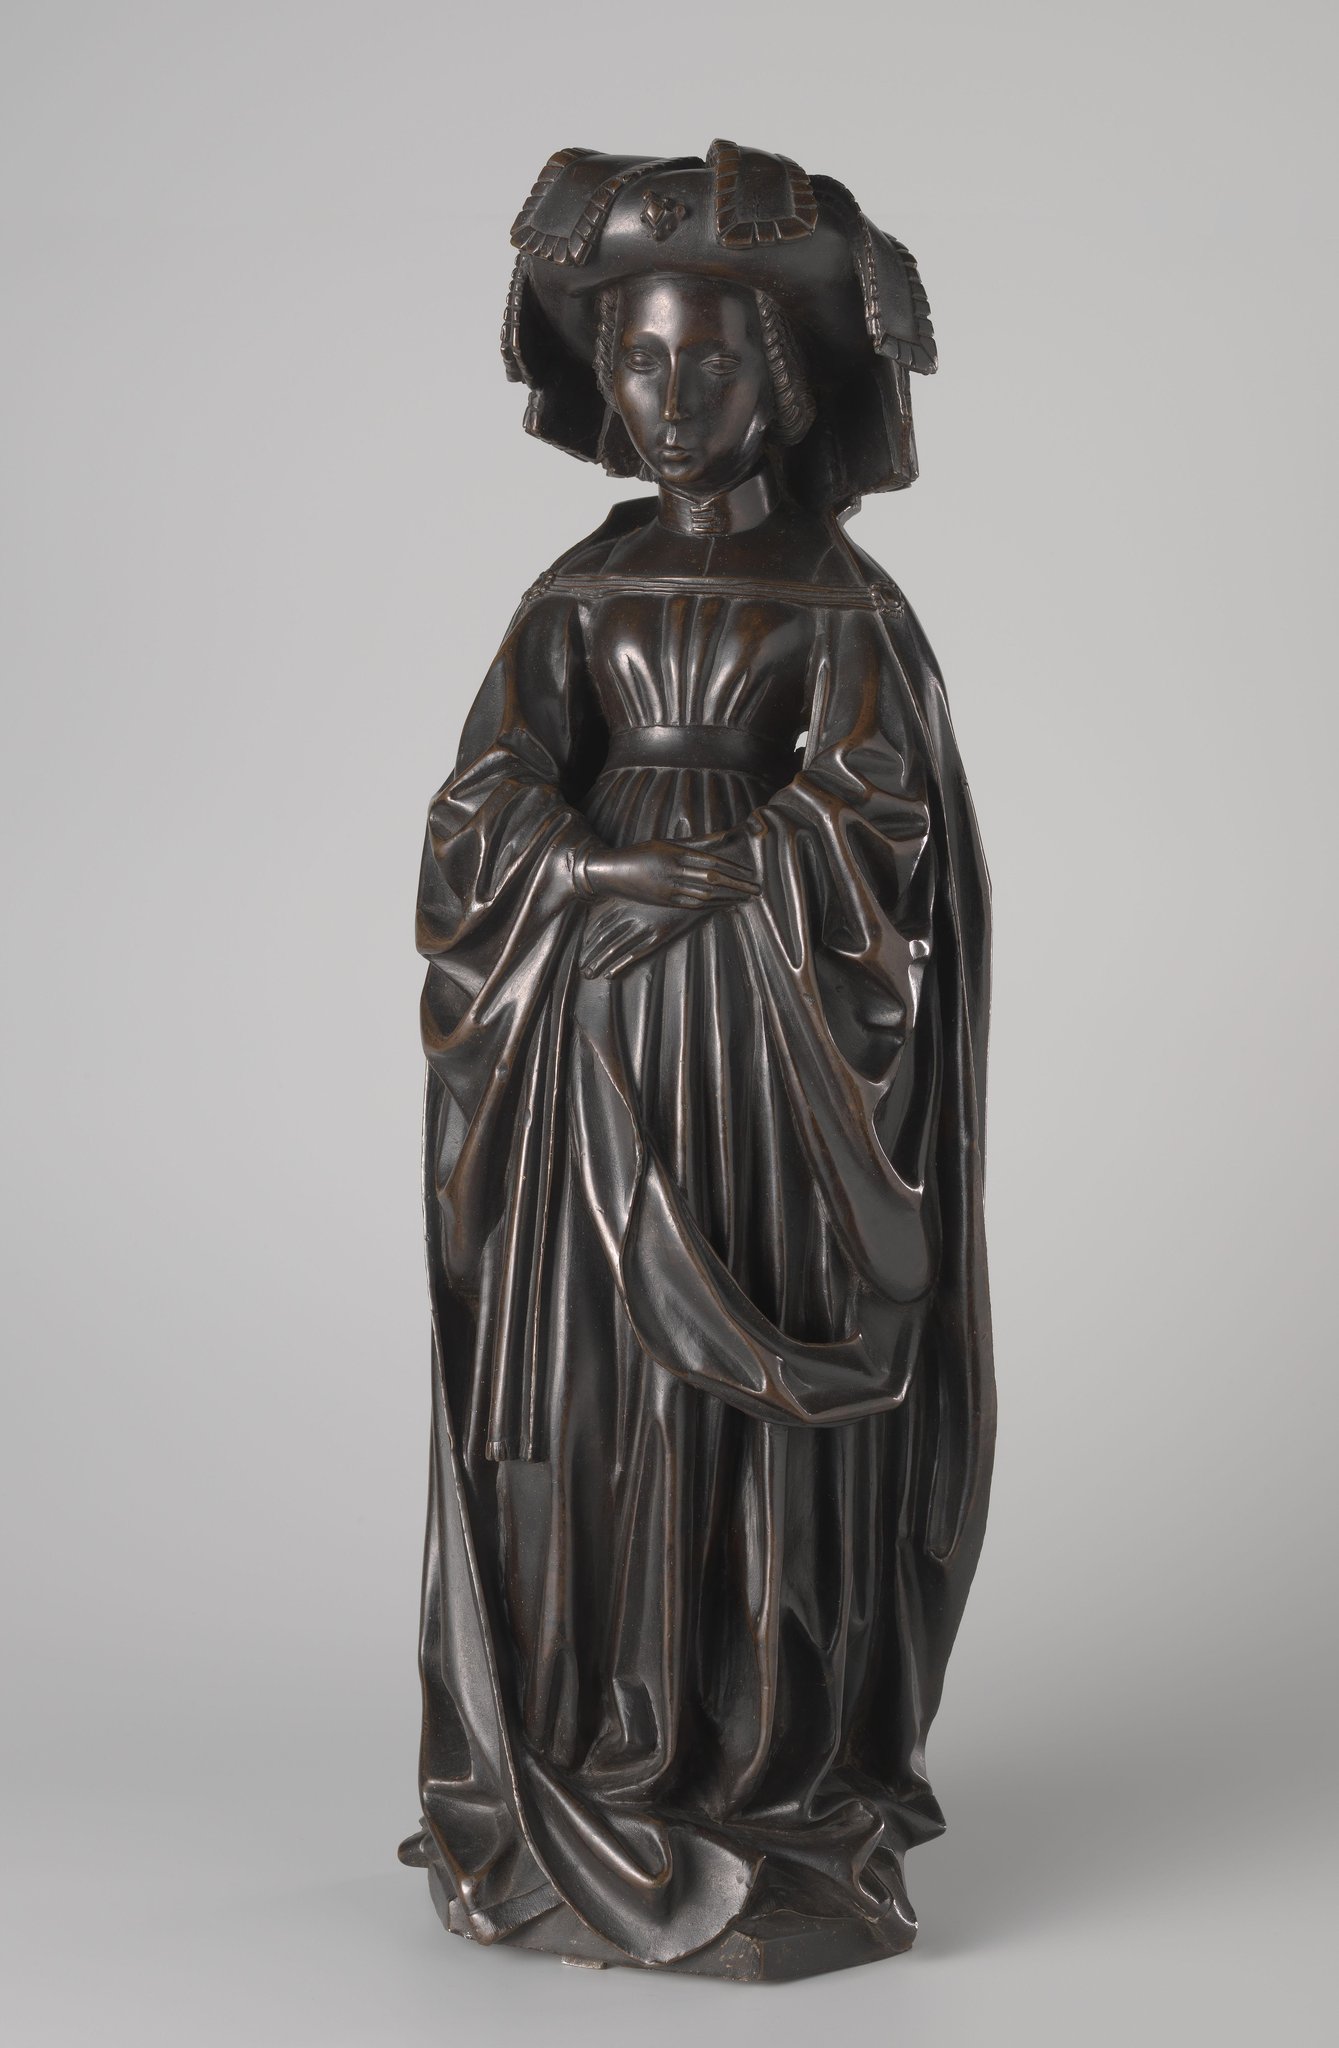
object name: tomb figure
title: Isabella van Bourbon & Pleurants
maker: renier van thienen (i)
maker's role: brazier, caster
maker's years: 1465-1498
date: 1475-1476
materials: bronze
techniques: casting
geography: brussels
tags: antwerp, 'pleurants', clothes, costume (+ women's clothes), nobility and patriciate; chivalry, knighthood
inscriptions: inscription, on the back, at the bottom, incised after casting and finishing: indistinguishable location mark, number, on the back, at the top, in modern white paint: ‘9’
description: Mary of Burgundy had a mausoleum erected for her late mother, Isabella of Bourbon. Only the gisant (tomb effigy) of Isabella and 10 of the 24 figures originally surrounding the tomb have been preserved. These pleurants (weepers) represent five generations of grieving forebears. While the tomb commemorated Isabella, it mainly served to advertise Mary’s noble lineage. She was the sole remaining heir of the Dukes of Burgundy and therefore a highly desirable consort. A year after the monument was completed, she married Maximilian of Habsburg, whereby the Burgundian Netherlands became part of the vast Holy Roman Empire.